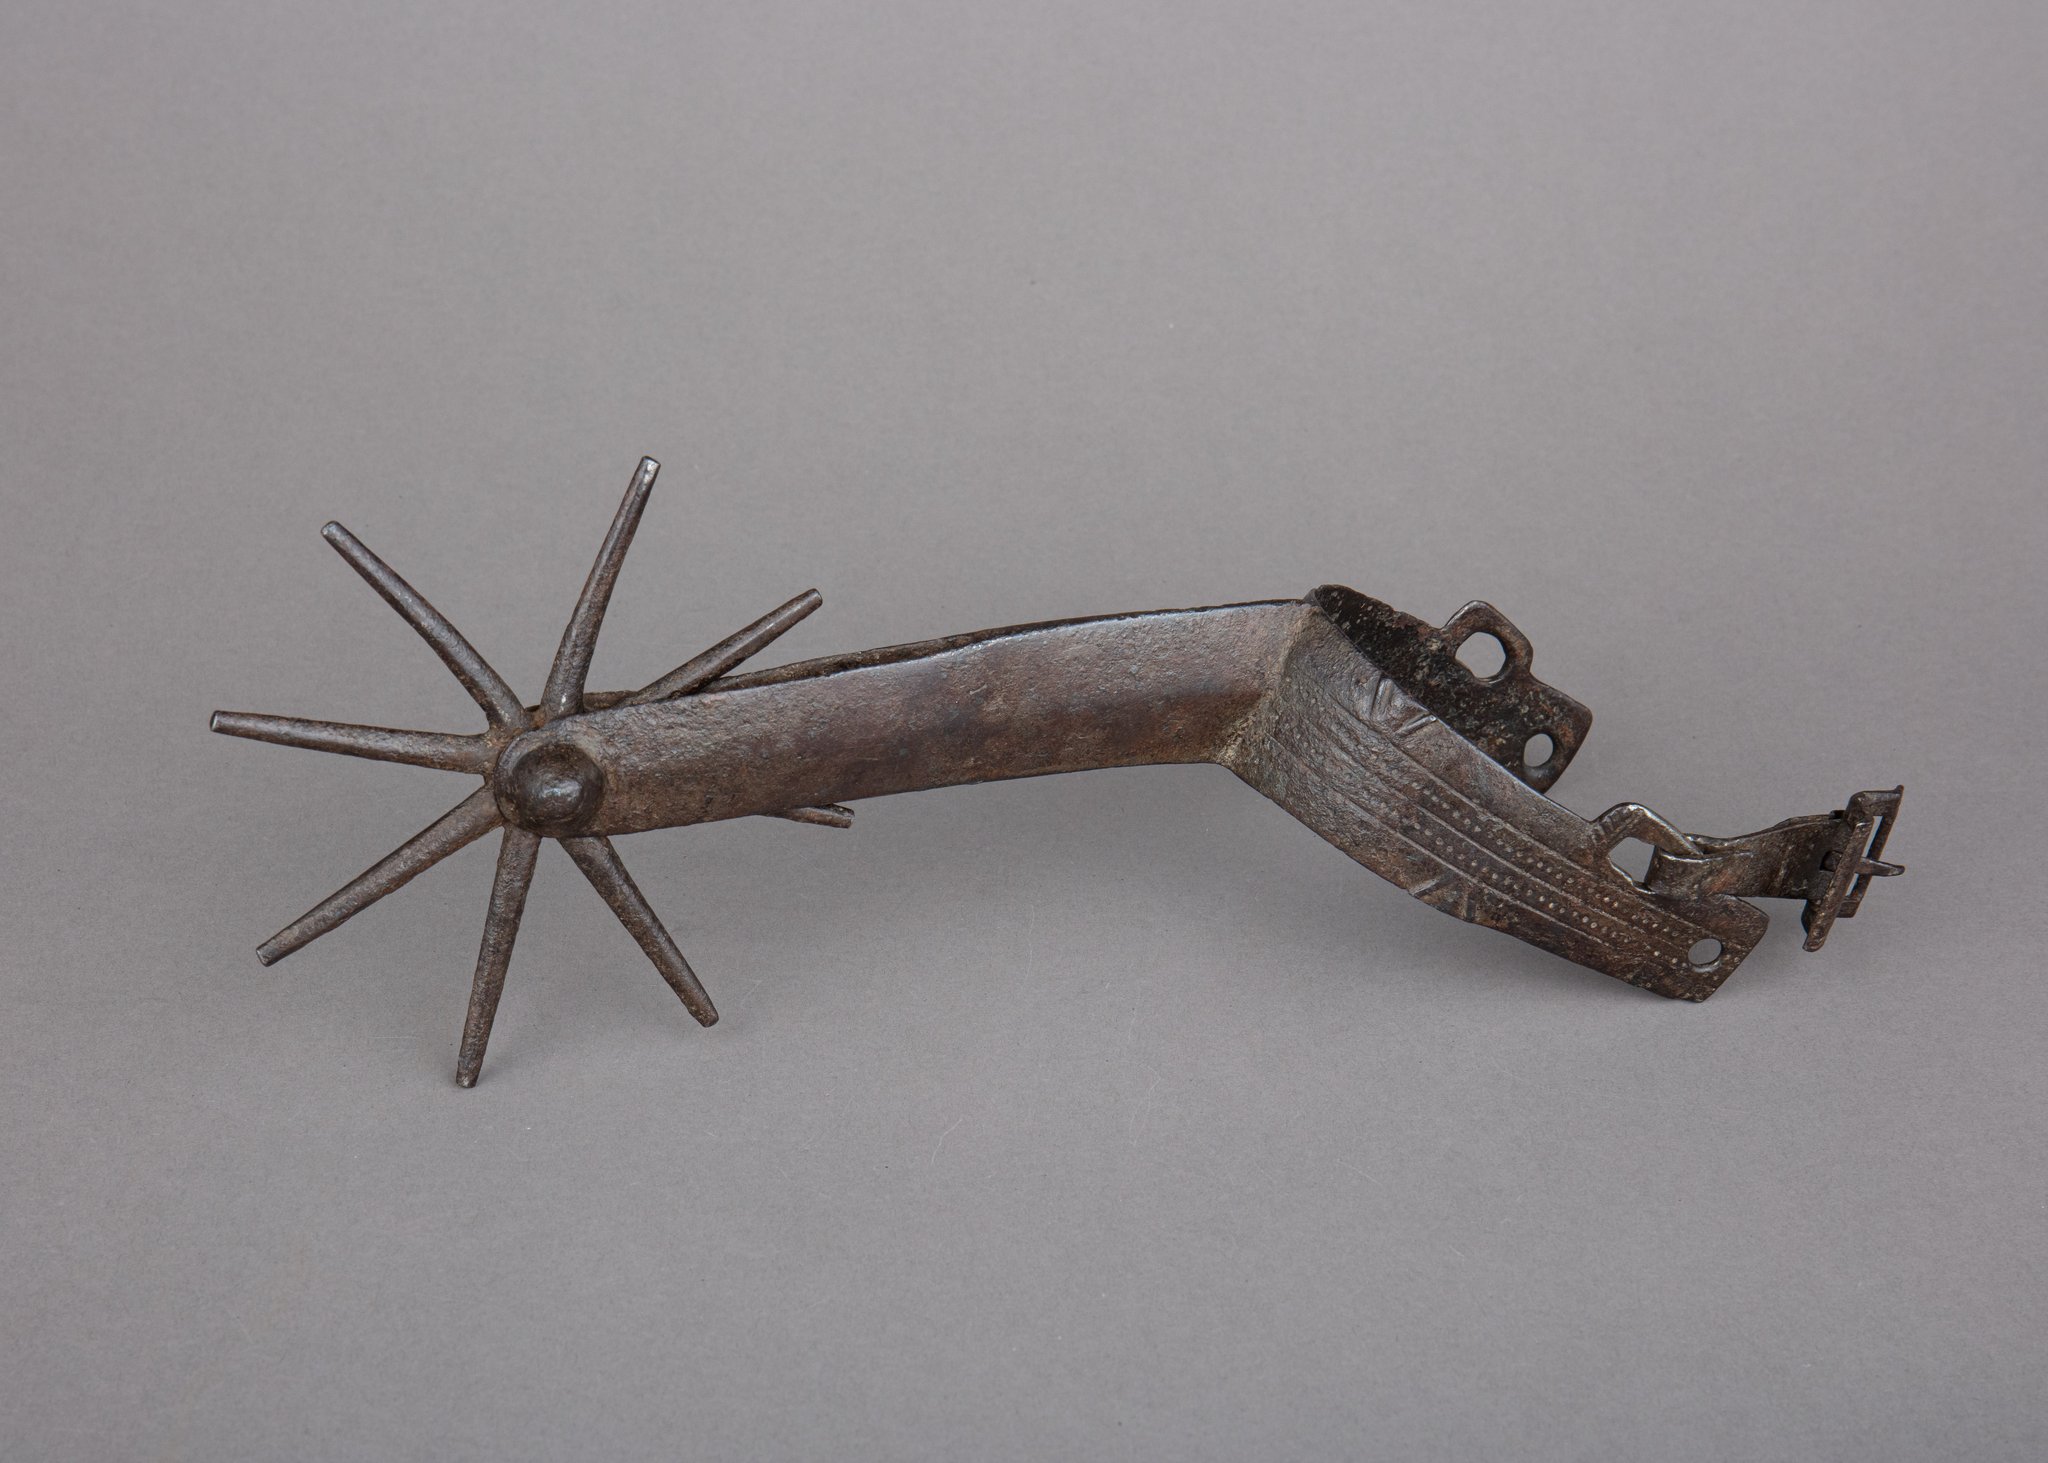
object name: spur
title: Rowel Spur (Right)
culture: hungarian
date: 1500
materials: metal alloy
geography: hungary